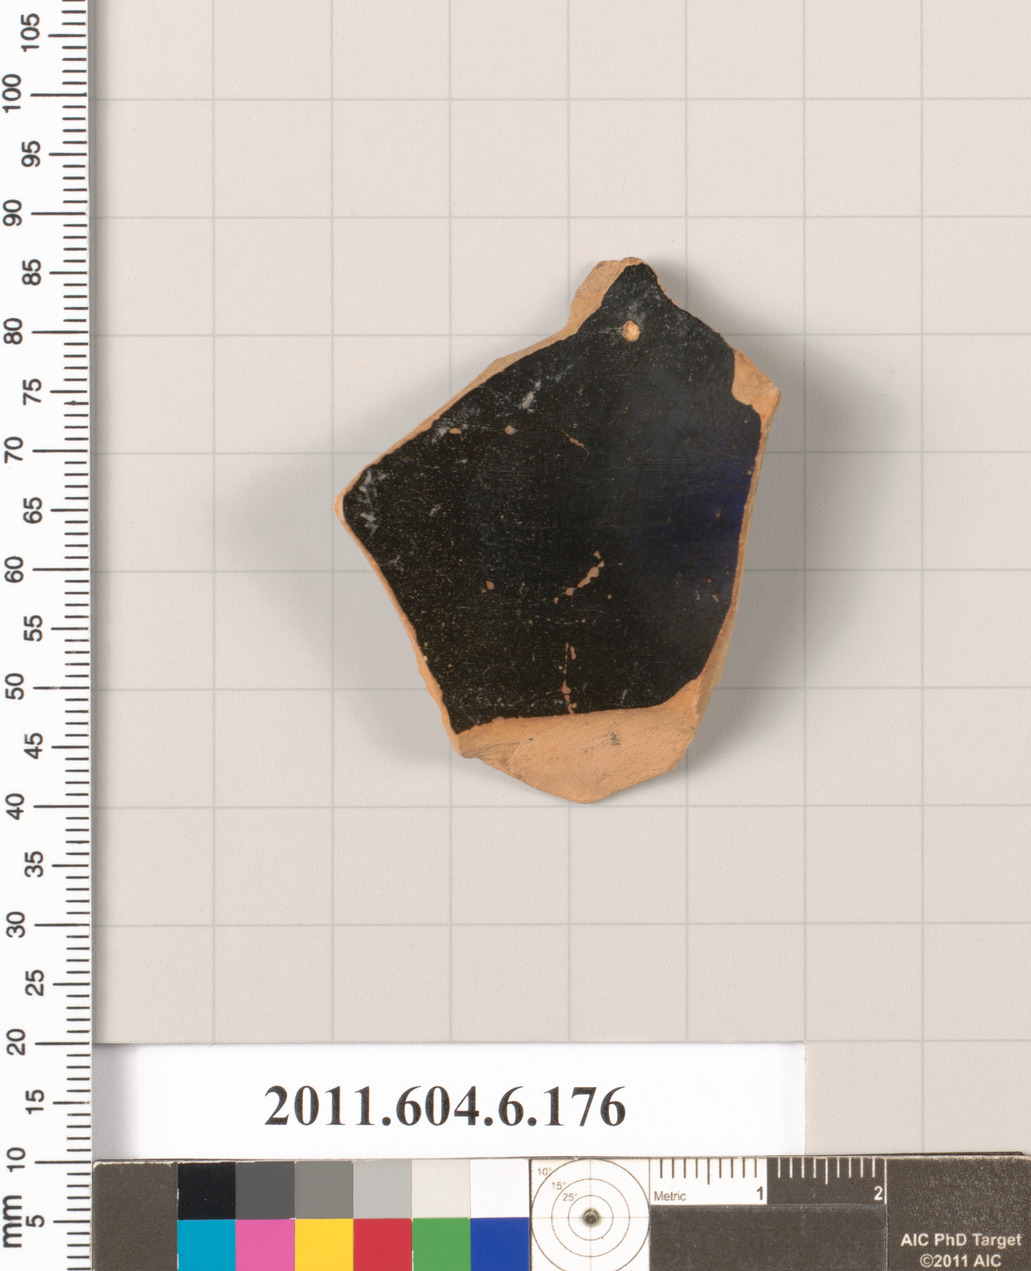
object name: oinochoe fragment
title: Terracotta fragment of an oinochoe (jug)?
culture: greek, attic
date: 500-401 BCE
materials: terracotta